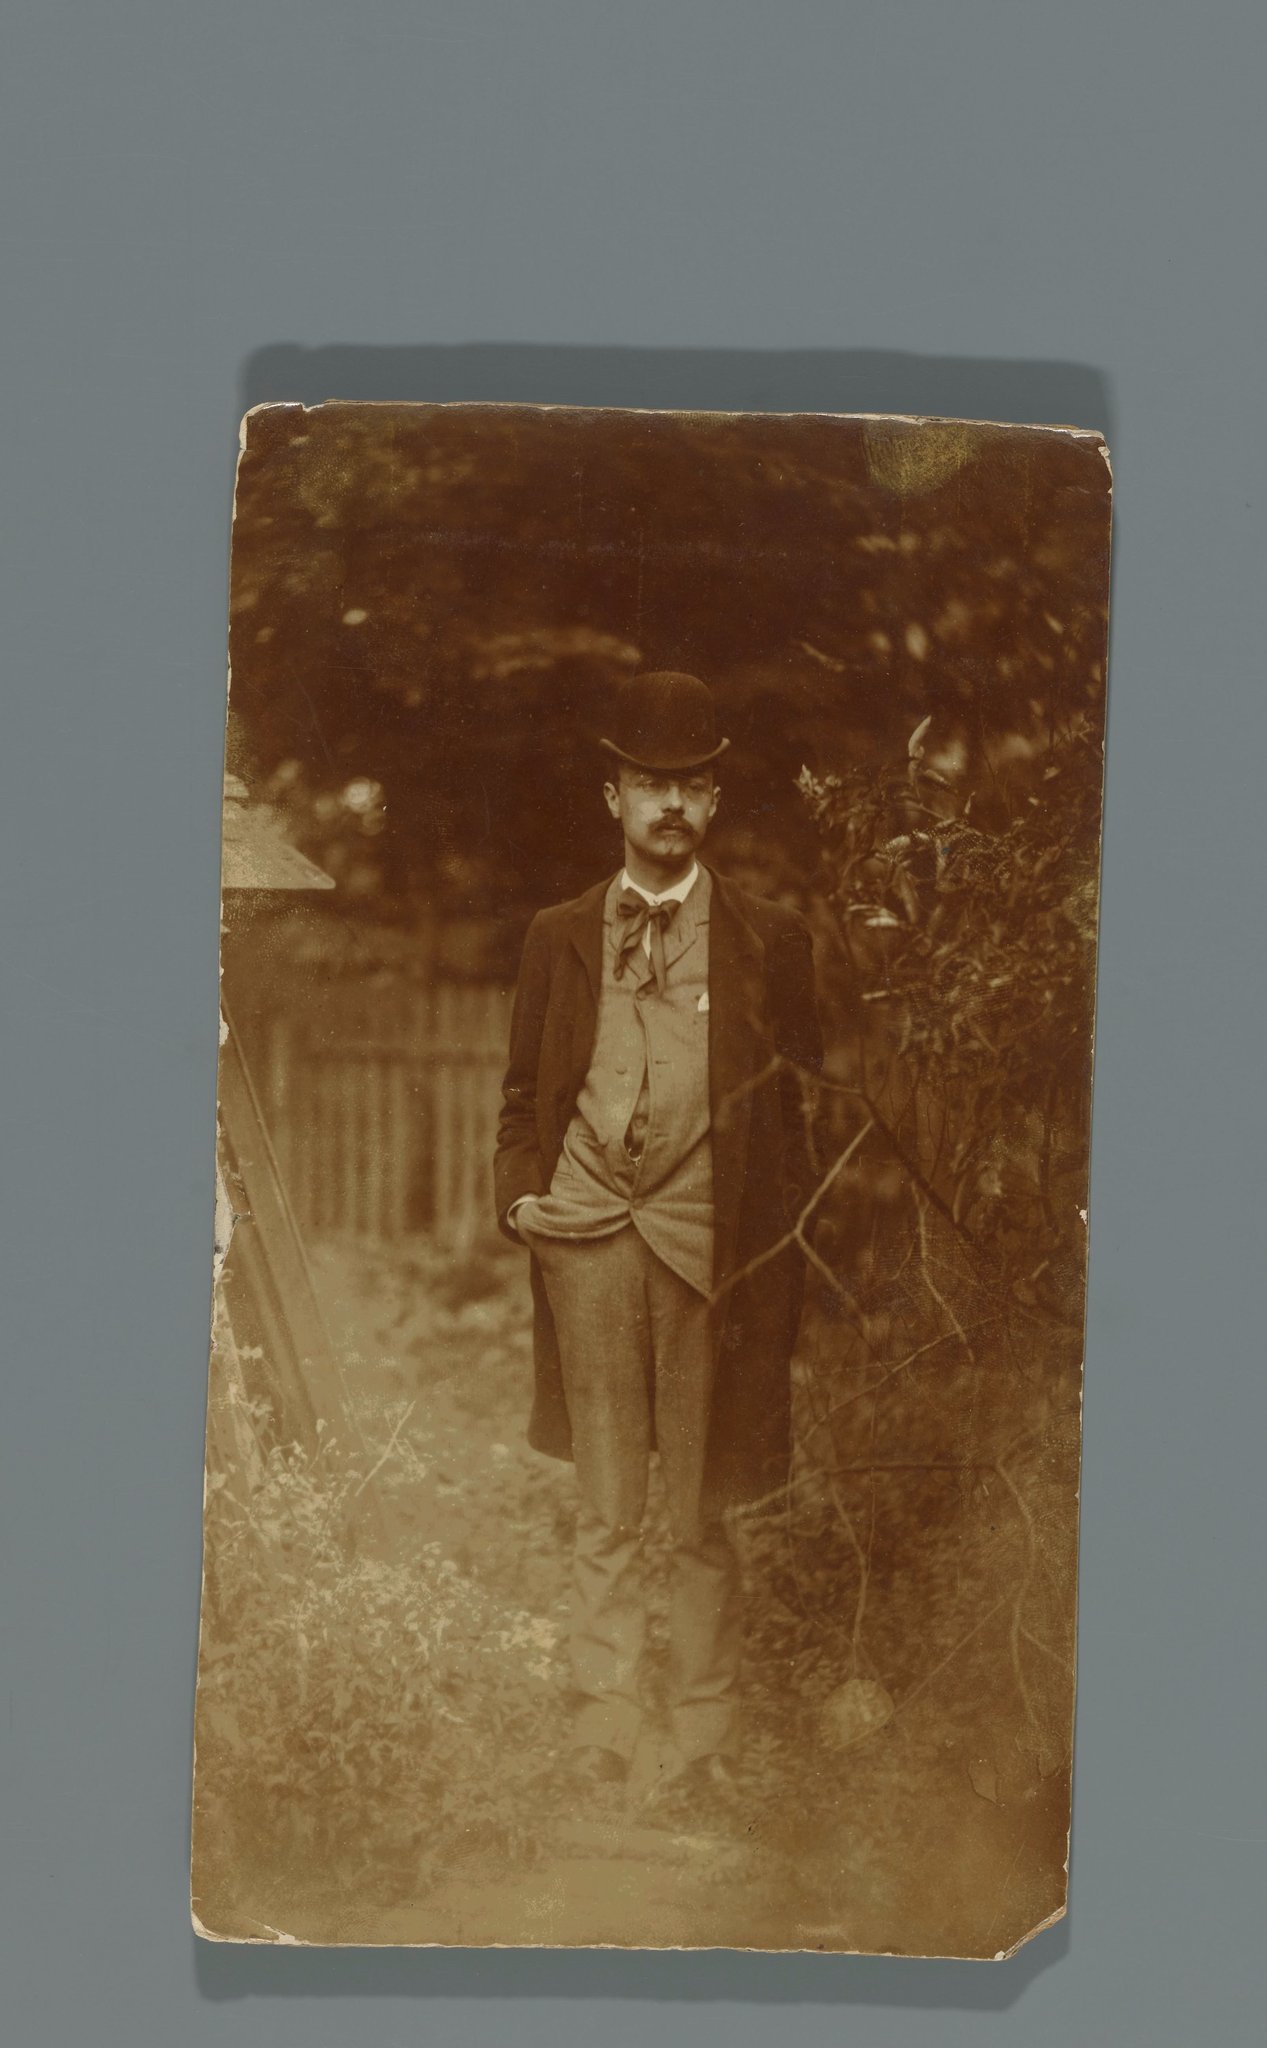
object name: photograph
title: Portrait of the Composer Alphons Diepenbrock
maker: joseph jessurun de mesquita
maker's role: fotograaf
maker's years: 1865-1890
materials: photographic support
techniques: gelatin silver print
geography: netherlands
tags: alphons diepenbrock, portrait of composer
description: Jessurun was the person responsible for introducing the late 19th-century painters and writers – called the ‘Tachtigers’ (Eightiers) – to the new prospects of photography. This portrait of the famous composer in his rumpled suit is an honest unadorned characterization. Jessurun wrote a guide for amateur photographers in 1889. In 1890 he took his own life with potassium cyanide.